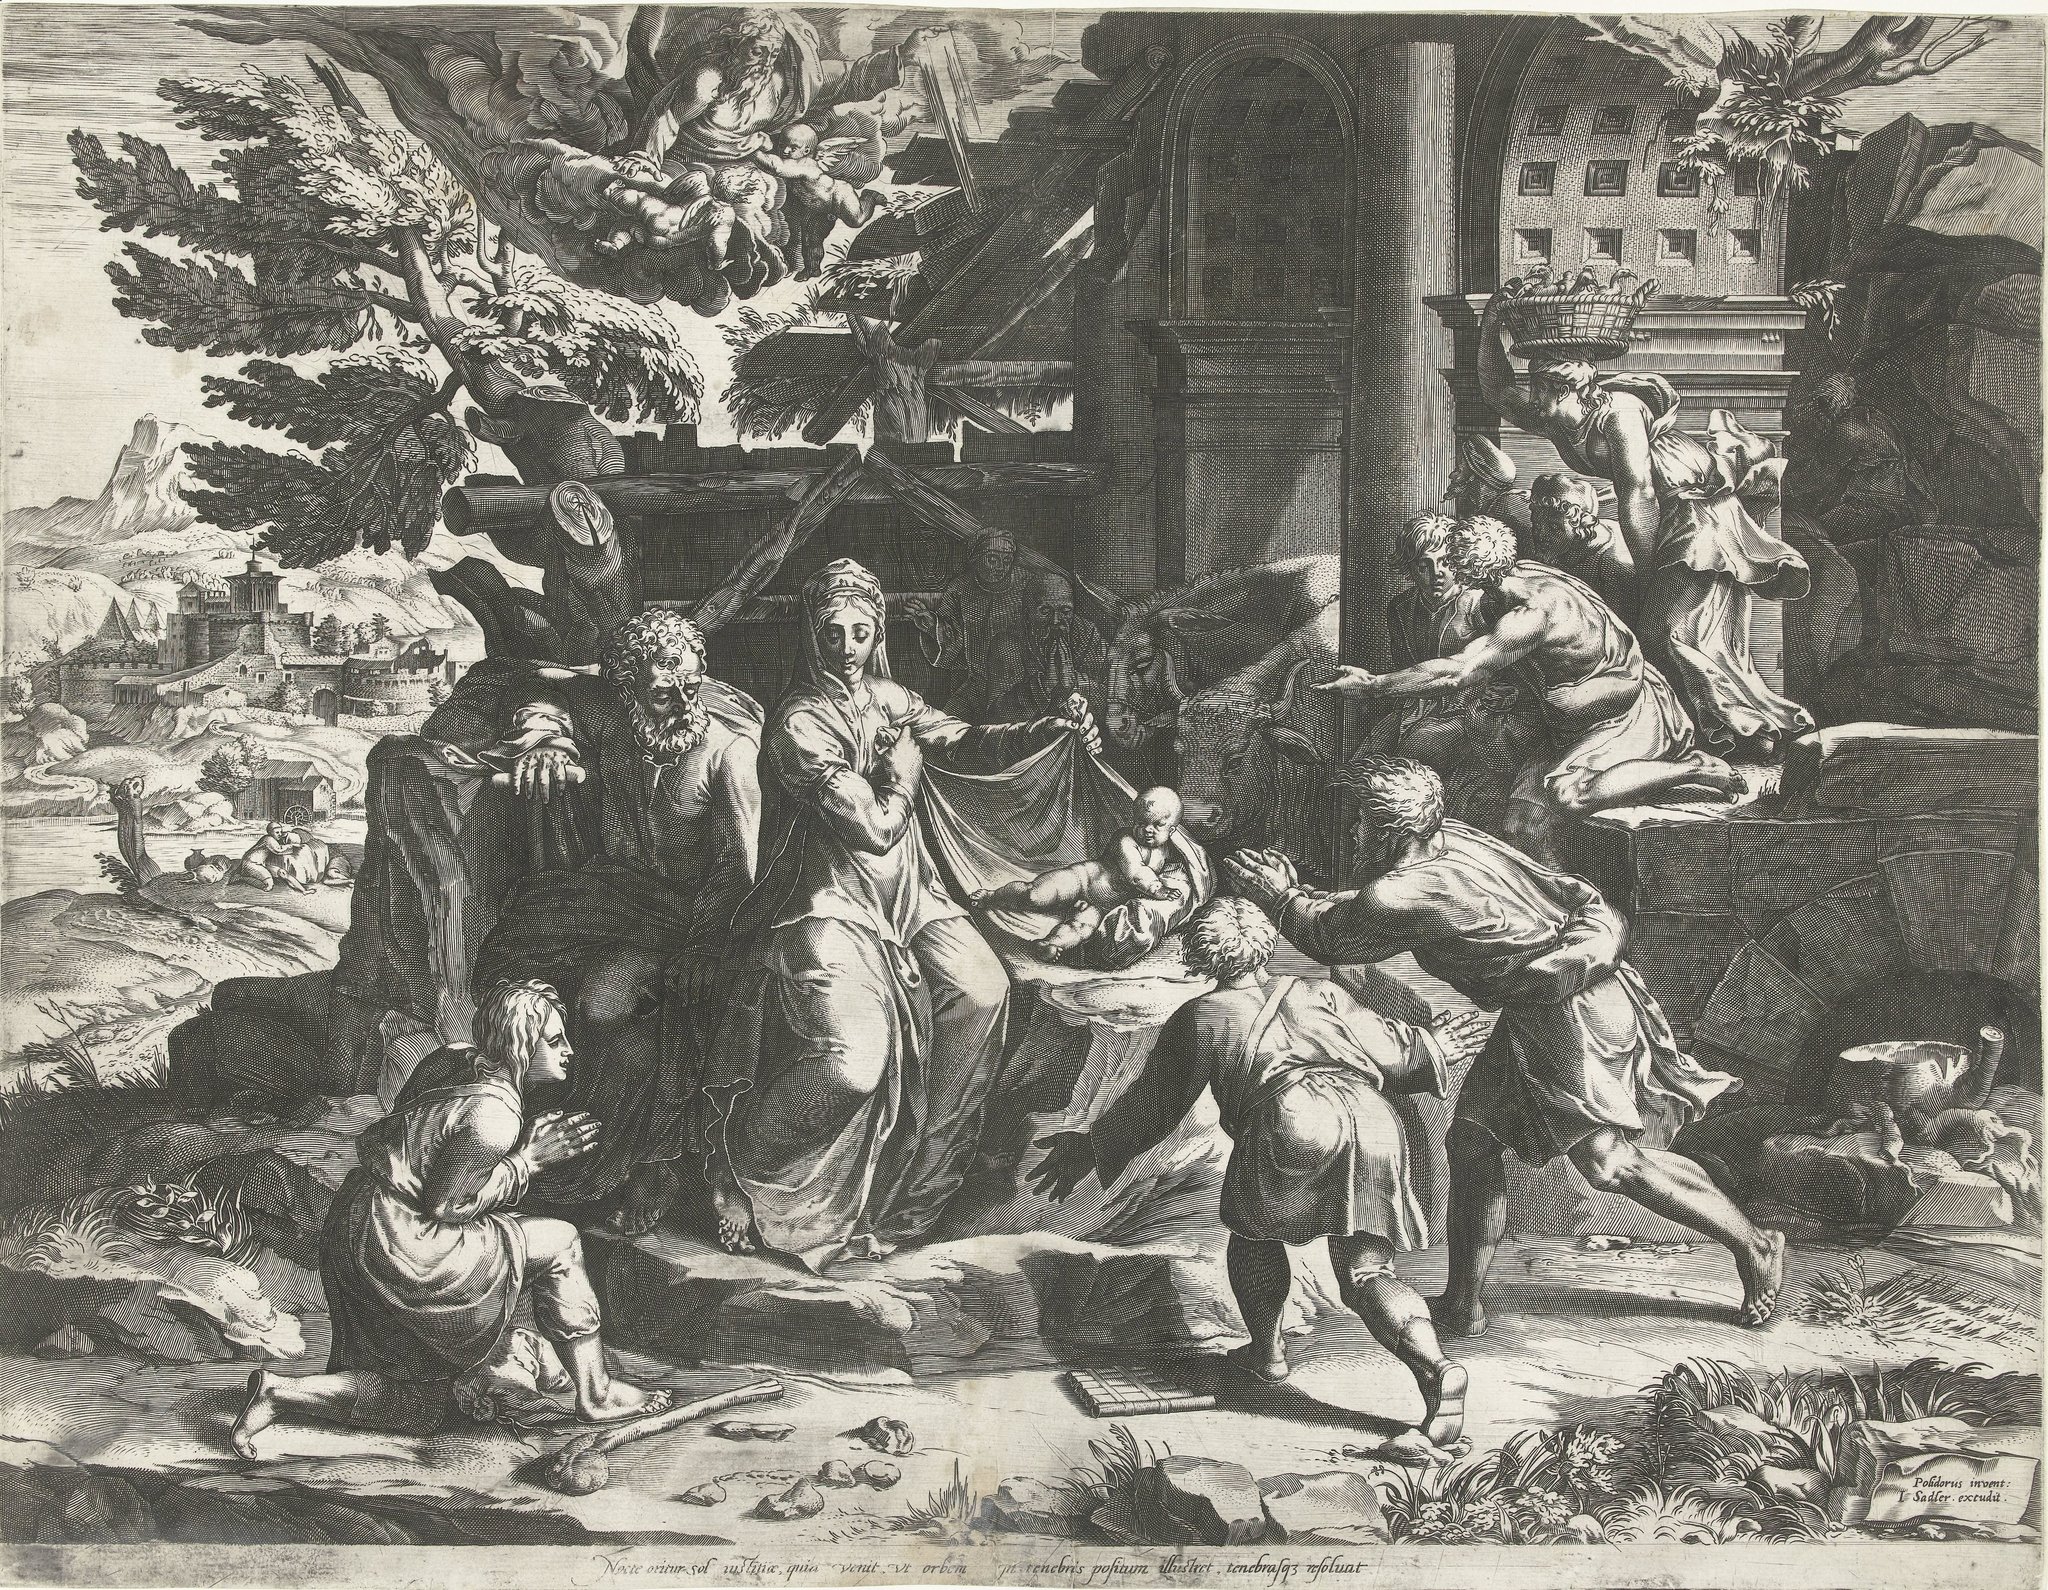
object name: print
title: Aanbidding door de herders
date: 1569-1600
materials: paper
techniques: engraving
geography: italy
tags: adoration of the christ-child by the shepherds; mary and joseph present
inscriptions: caption: ‘Hocte oritur sol iustitiae, quia venit, ut orbem / In tenebris positum inlustret, tenebrasq. resolvat.’, signature: ‘Polidorus. invent.’, address: ‘I. Sadler. excudit’, collector's mark: Lugt 240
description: In een landschap voor de ruine van een antiek gebouw zitten Maria en Jozef. Maria toont het kind, liggend in een doek, aan de herders. Jozef zit naast haar. Achter hen de os en de ezel. Herders komen aanlopen van rechts. Een van hen draagt een mand met pluimvee op het hoofd. Linksboven God met engeltjes in een wolk.